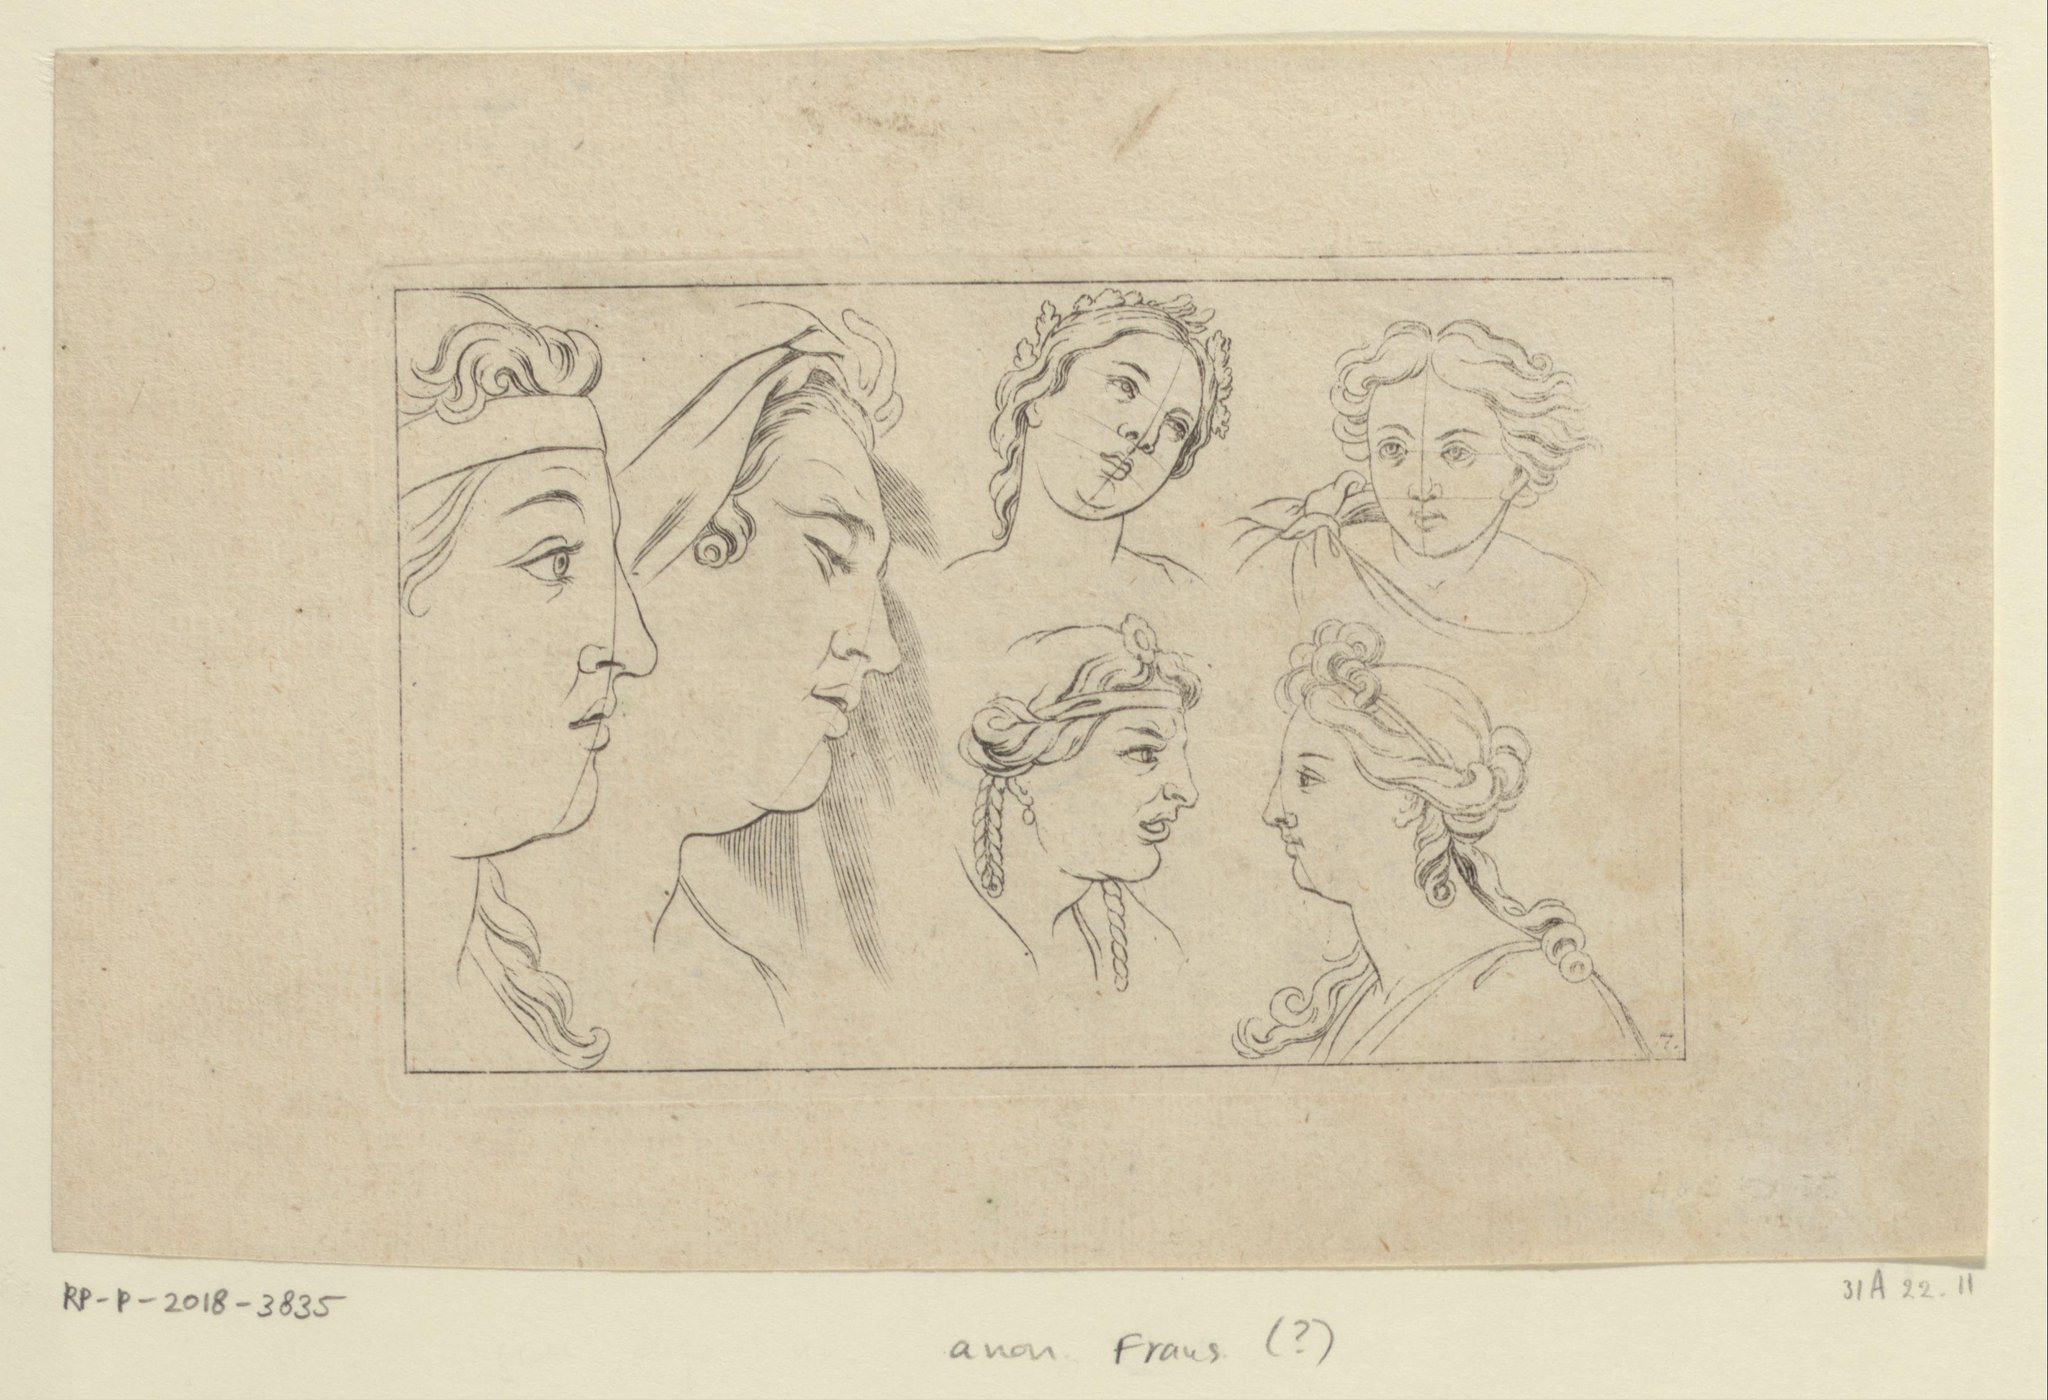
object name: print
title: Zes hoofden van vrouwen met verschillende emoties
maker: Anonymous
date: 1650-1799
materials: paper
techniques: etching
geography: france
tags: face, passions, emotions, affections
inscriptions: collector's mark: Lugt 2228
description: Dit betreft waarschijnlijk een tekenvoorbeeld.